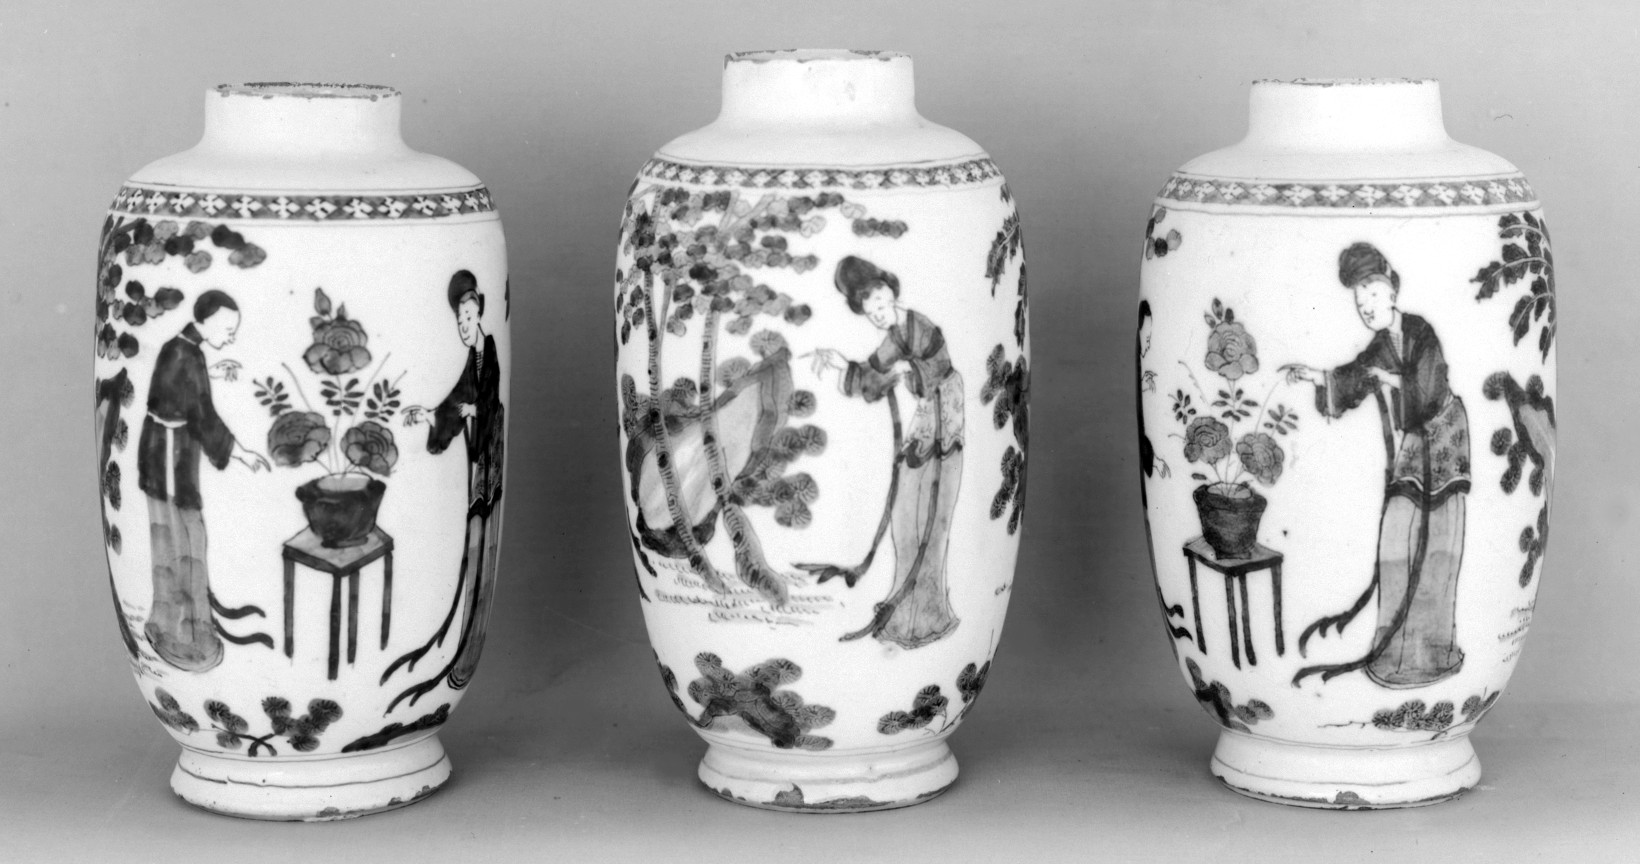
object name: vase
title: Vase (part of a garniture)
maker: de witte starre manufactory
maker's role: manufactory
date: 1723-1741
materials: earthenware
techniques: glazing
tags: human figures,flowers,trees